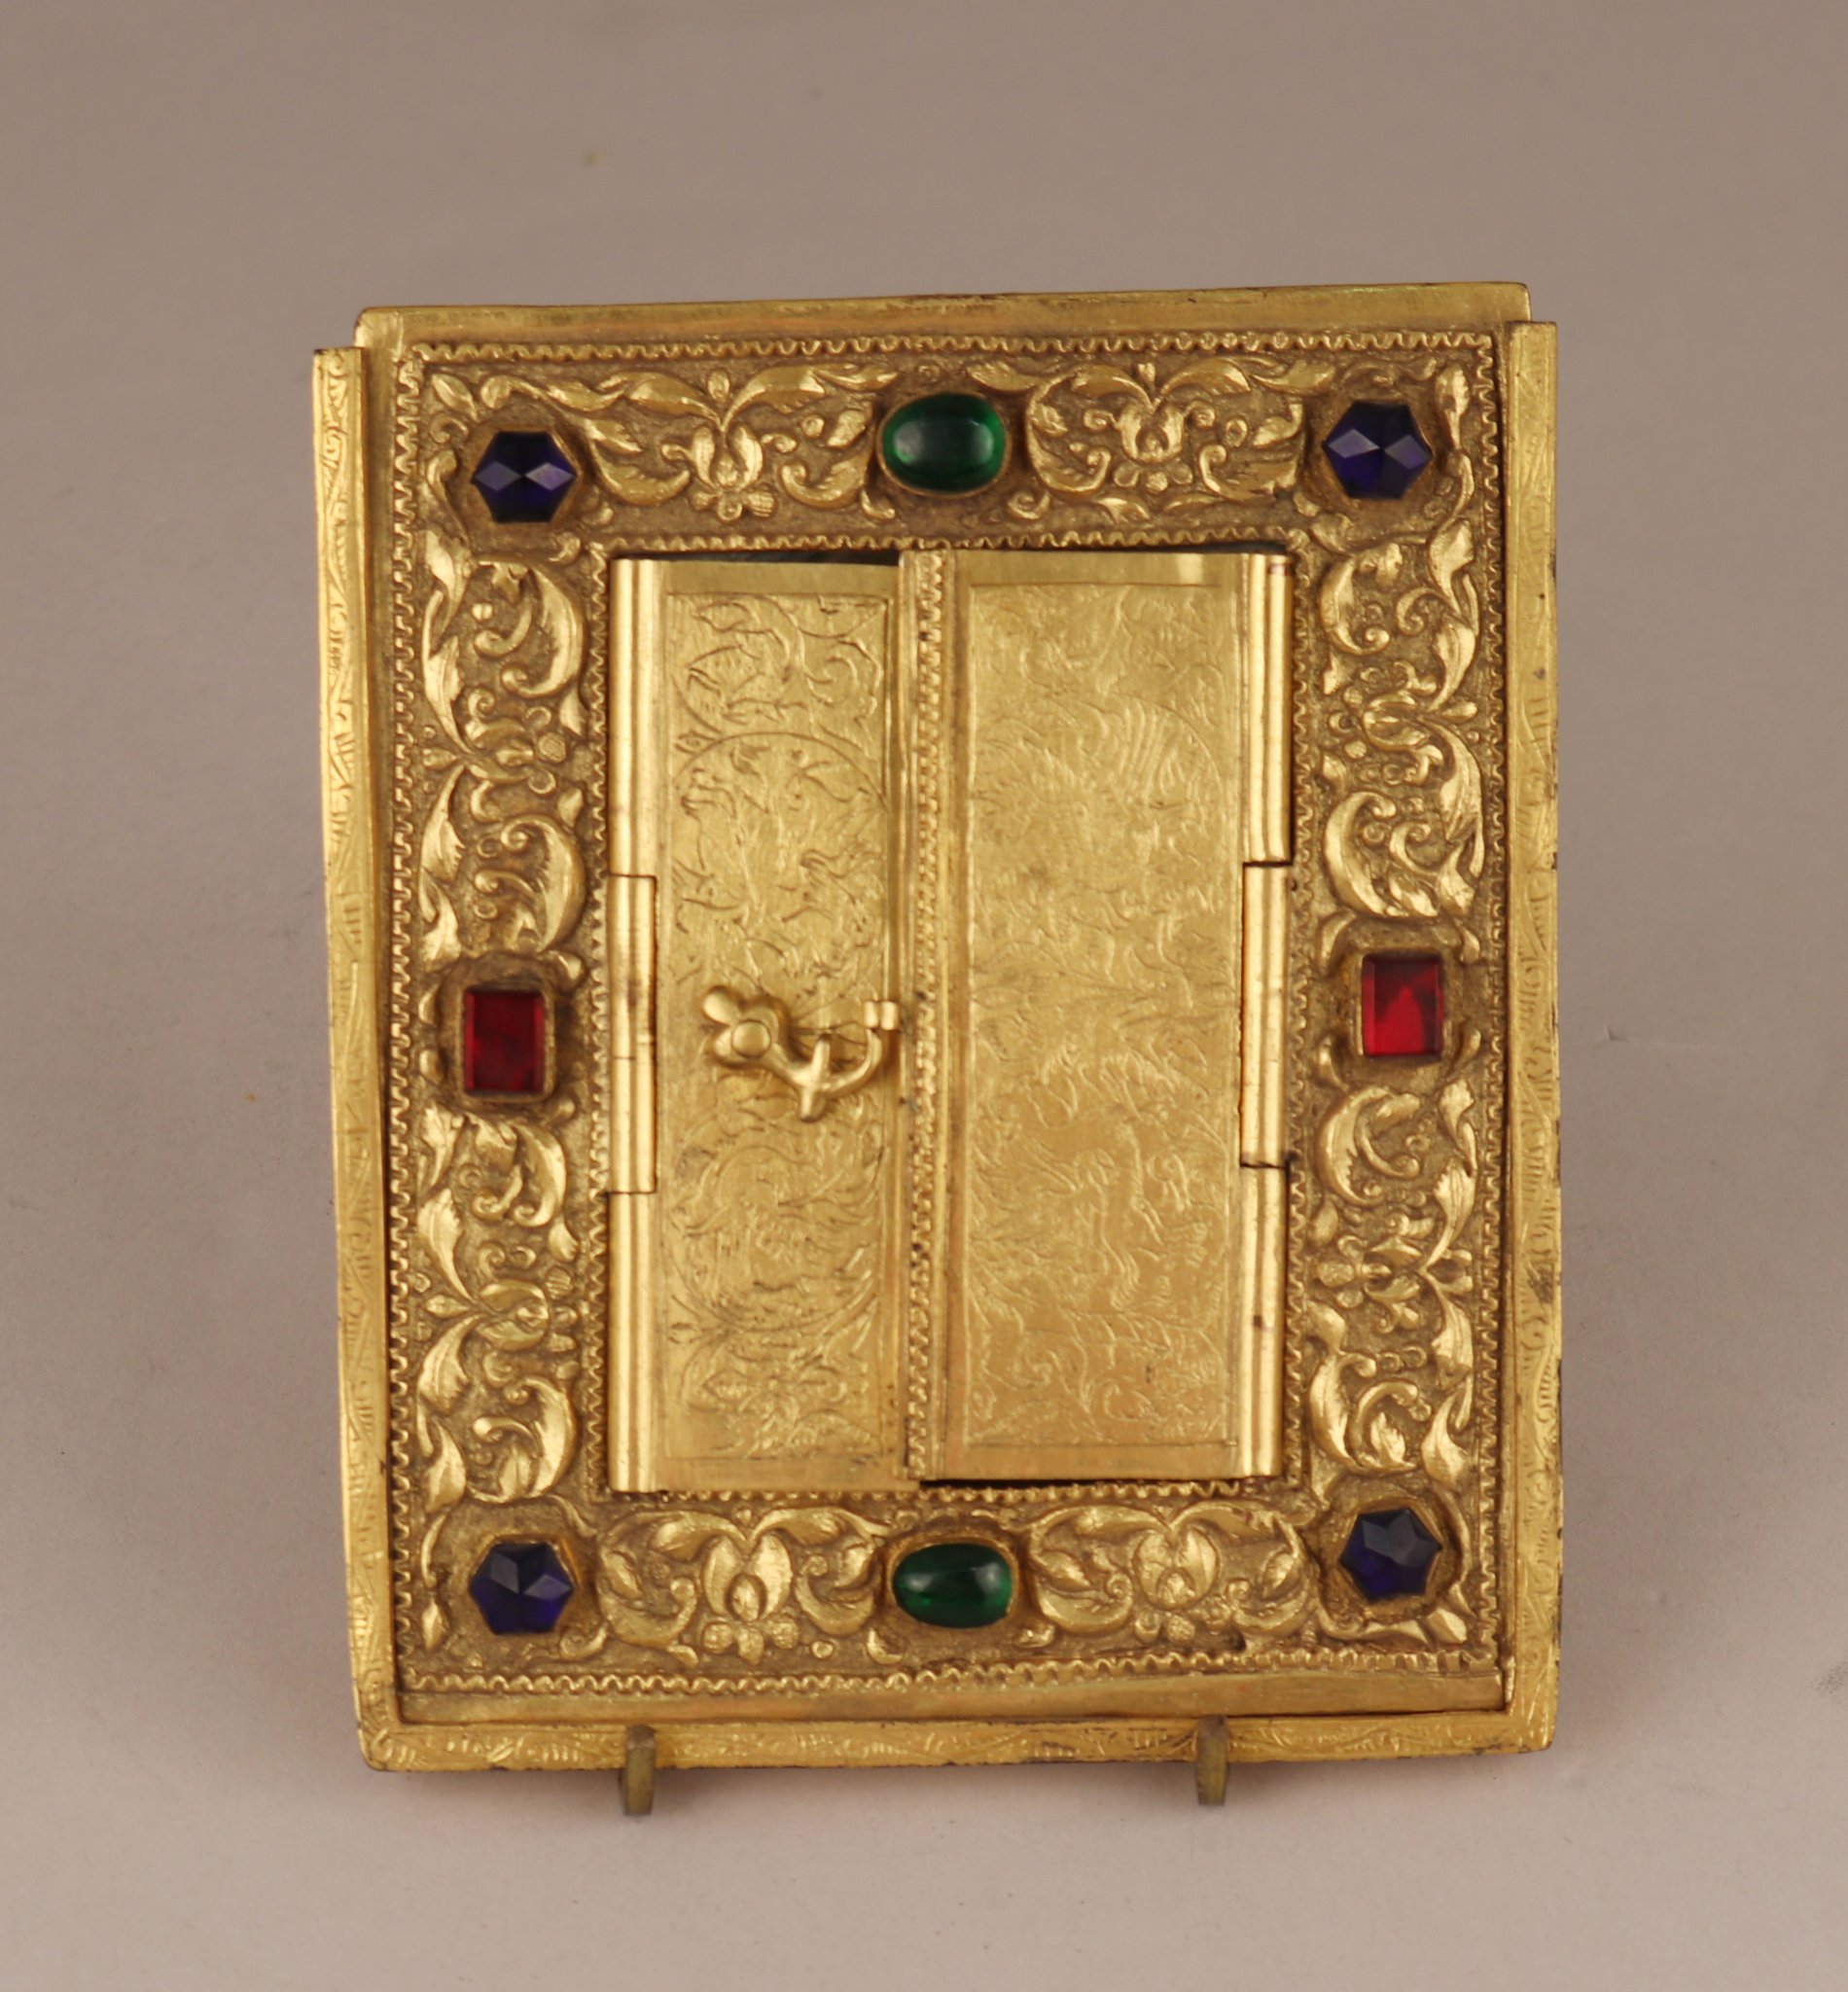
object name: mirror frame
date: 1801-1900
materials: metal, silver